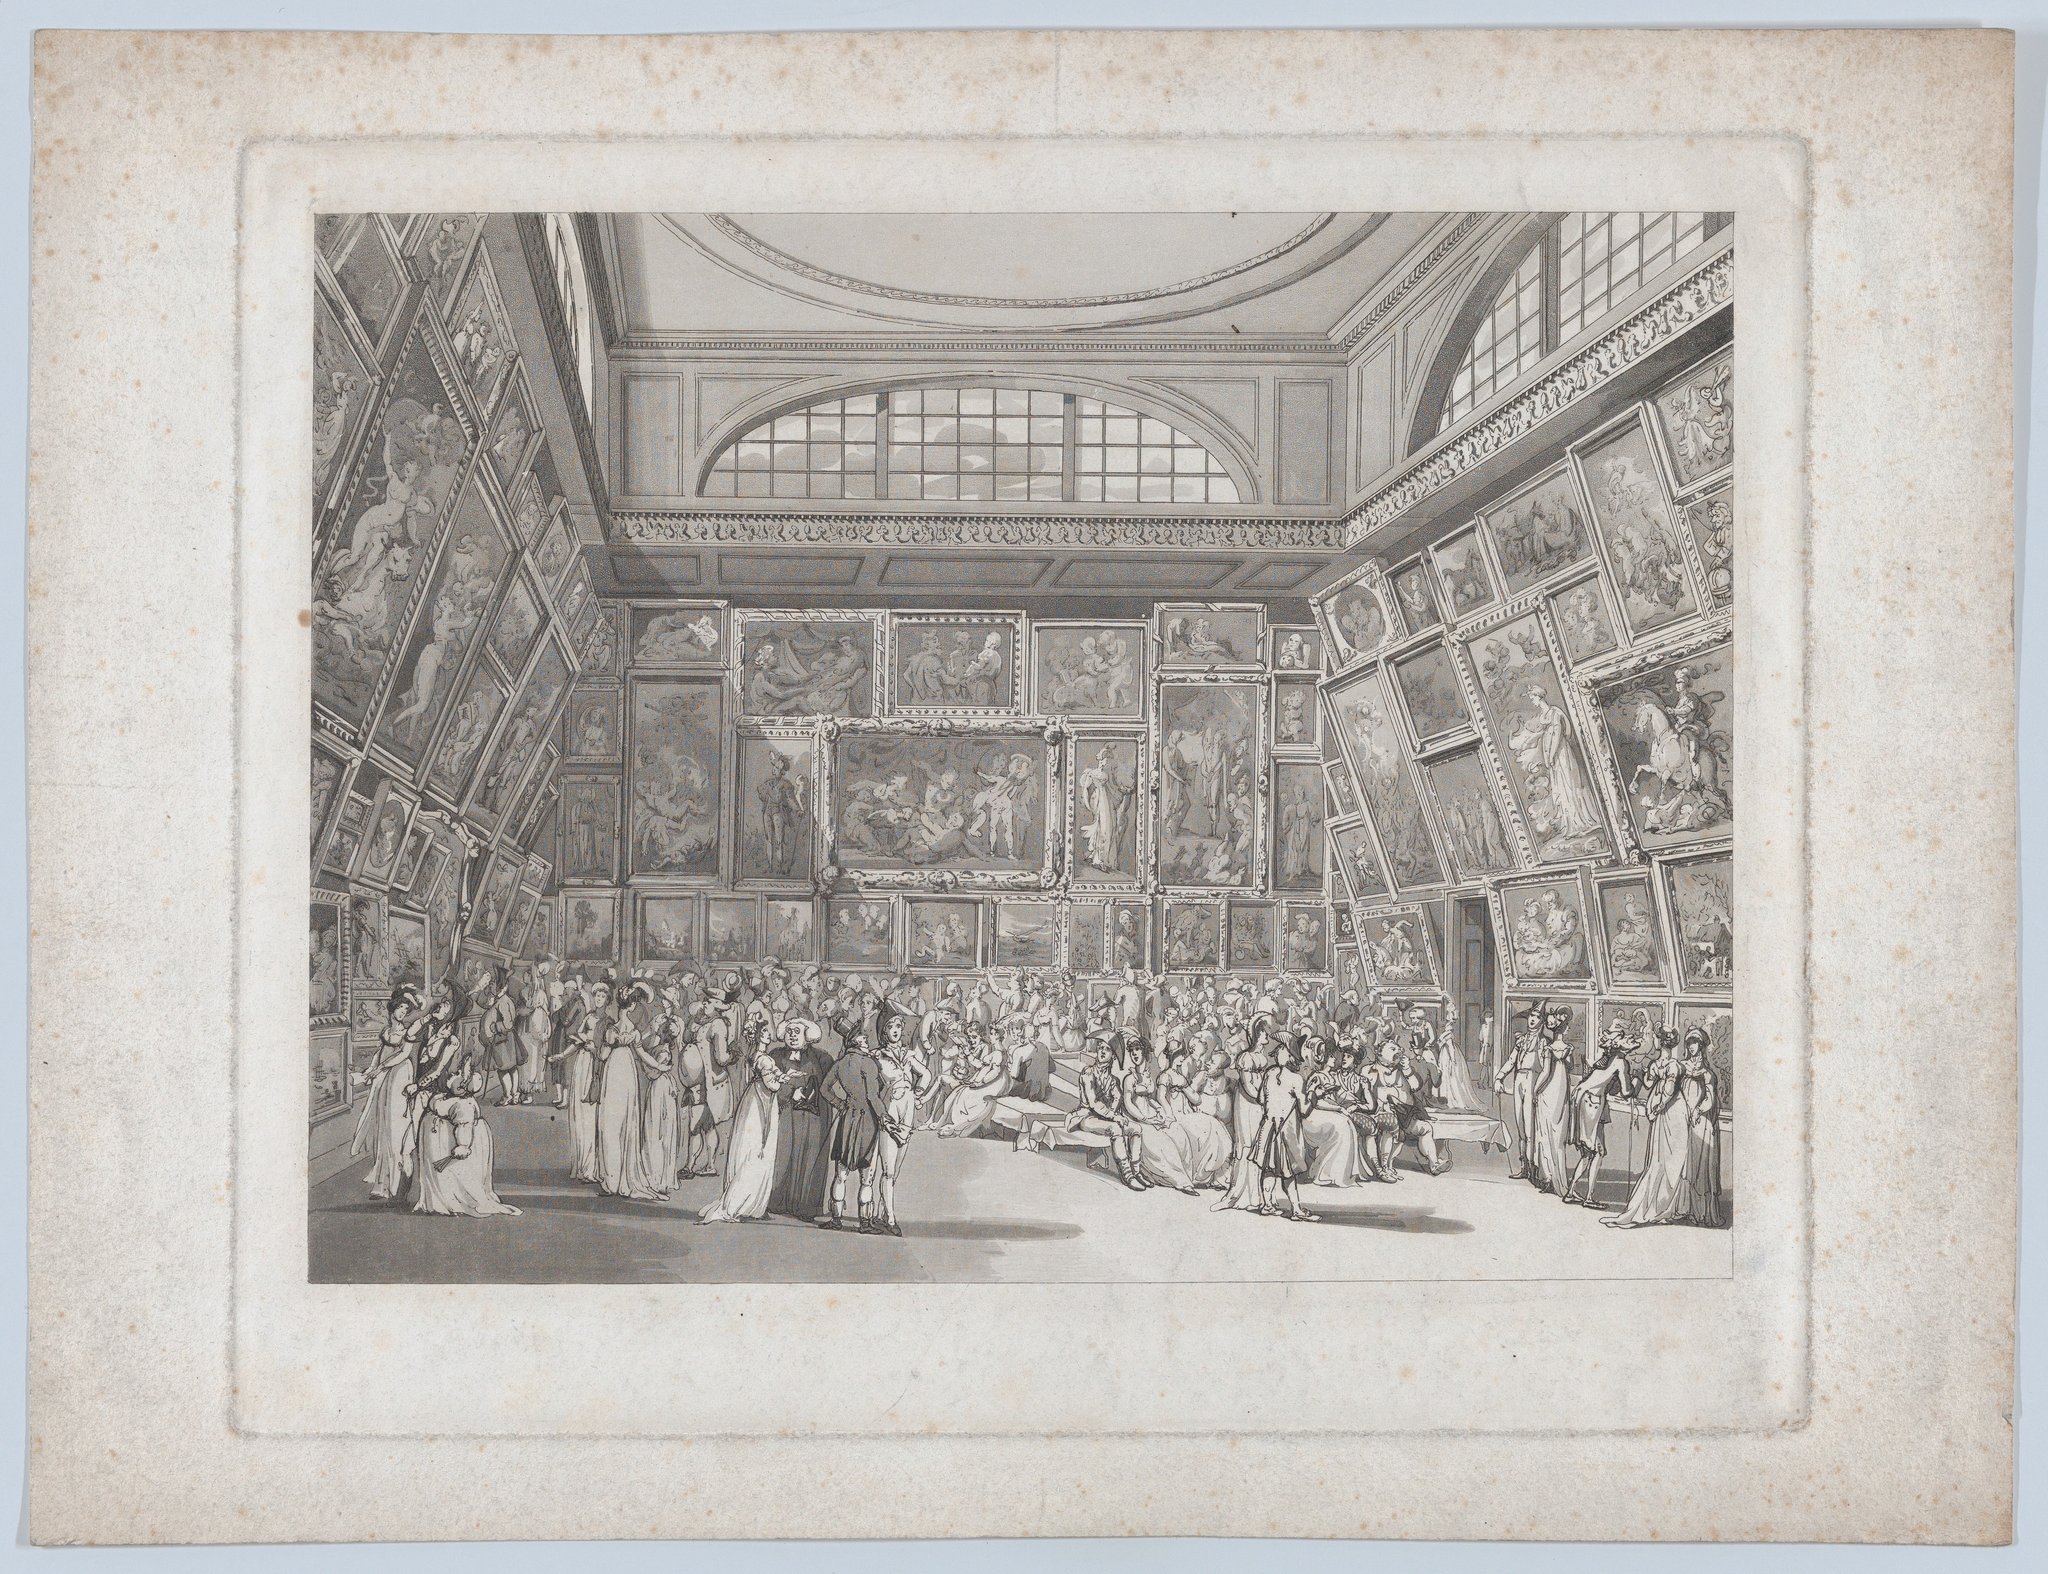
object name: print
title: Exhibition Room, Somerset House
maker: thomas rowlandson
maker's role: artist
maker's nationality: british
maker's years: 1757-1827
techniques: aquatint, etching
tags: crowd